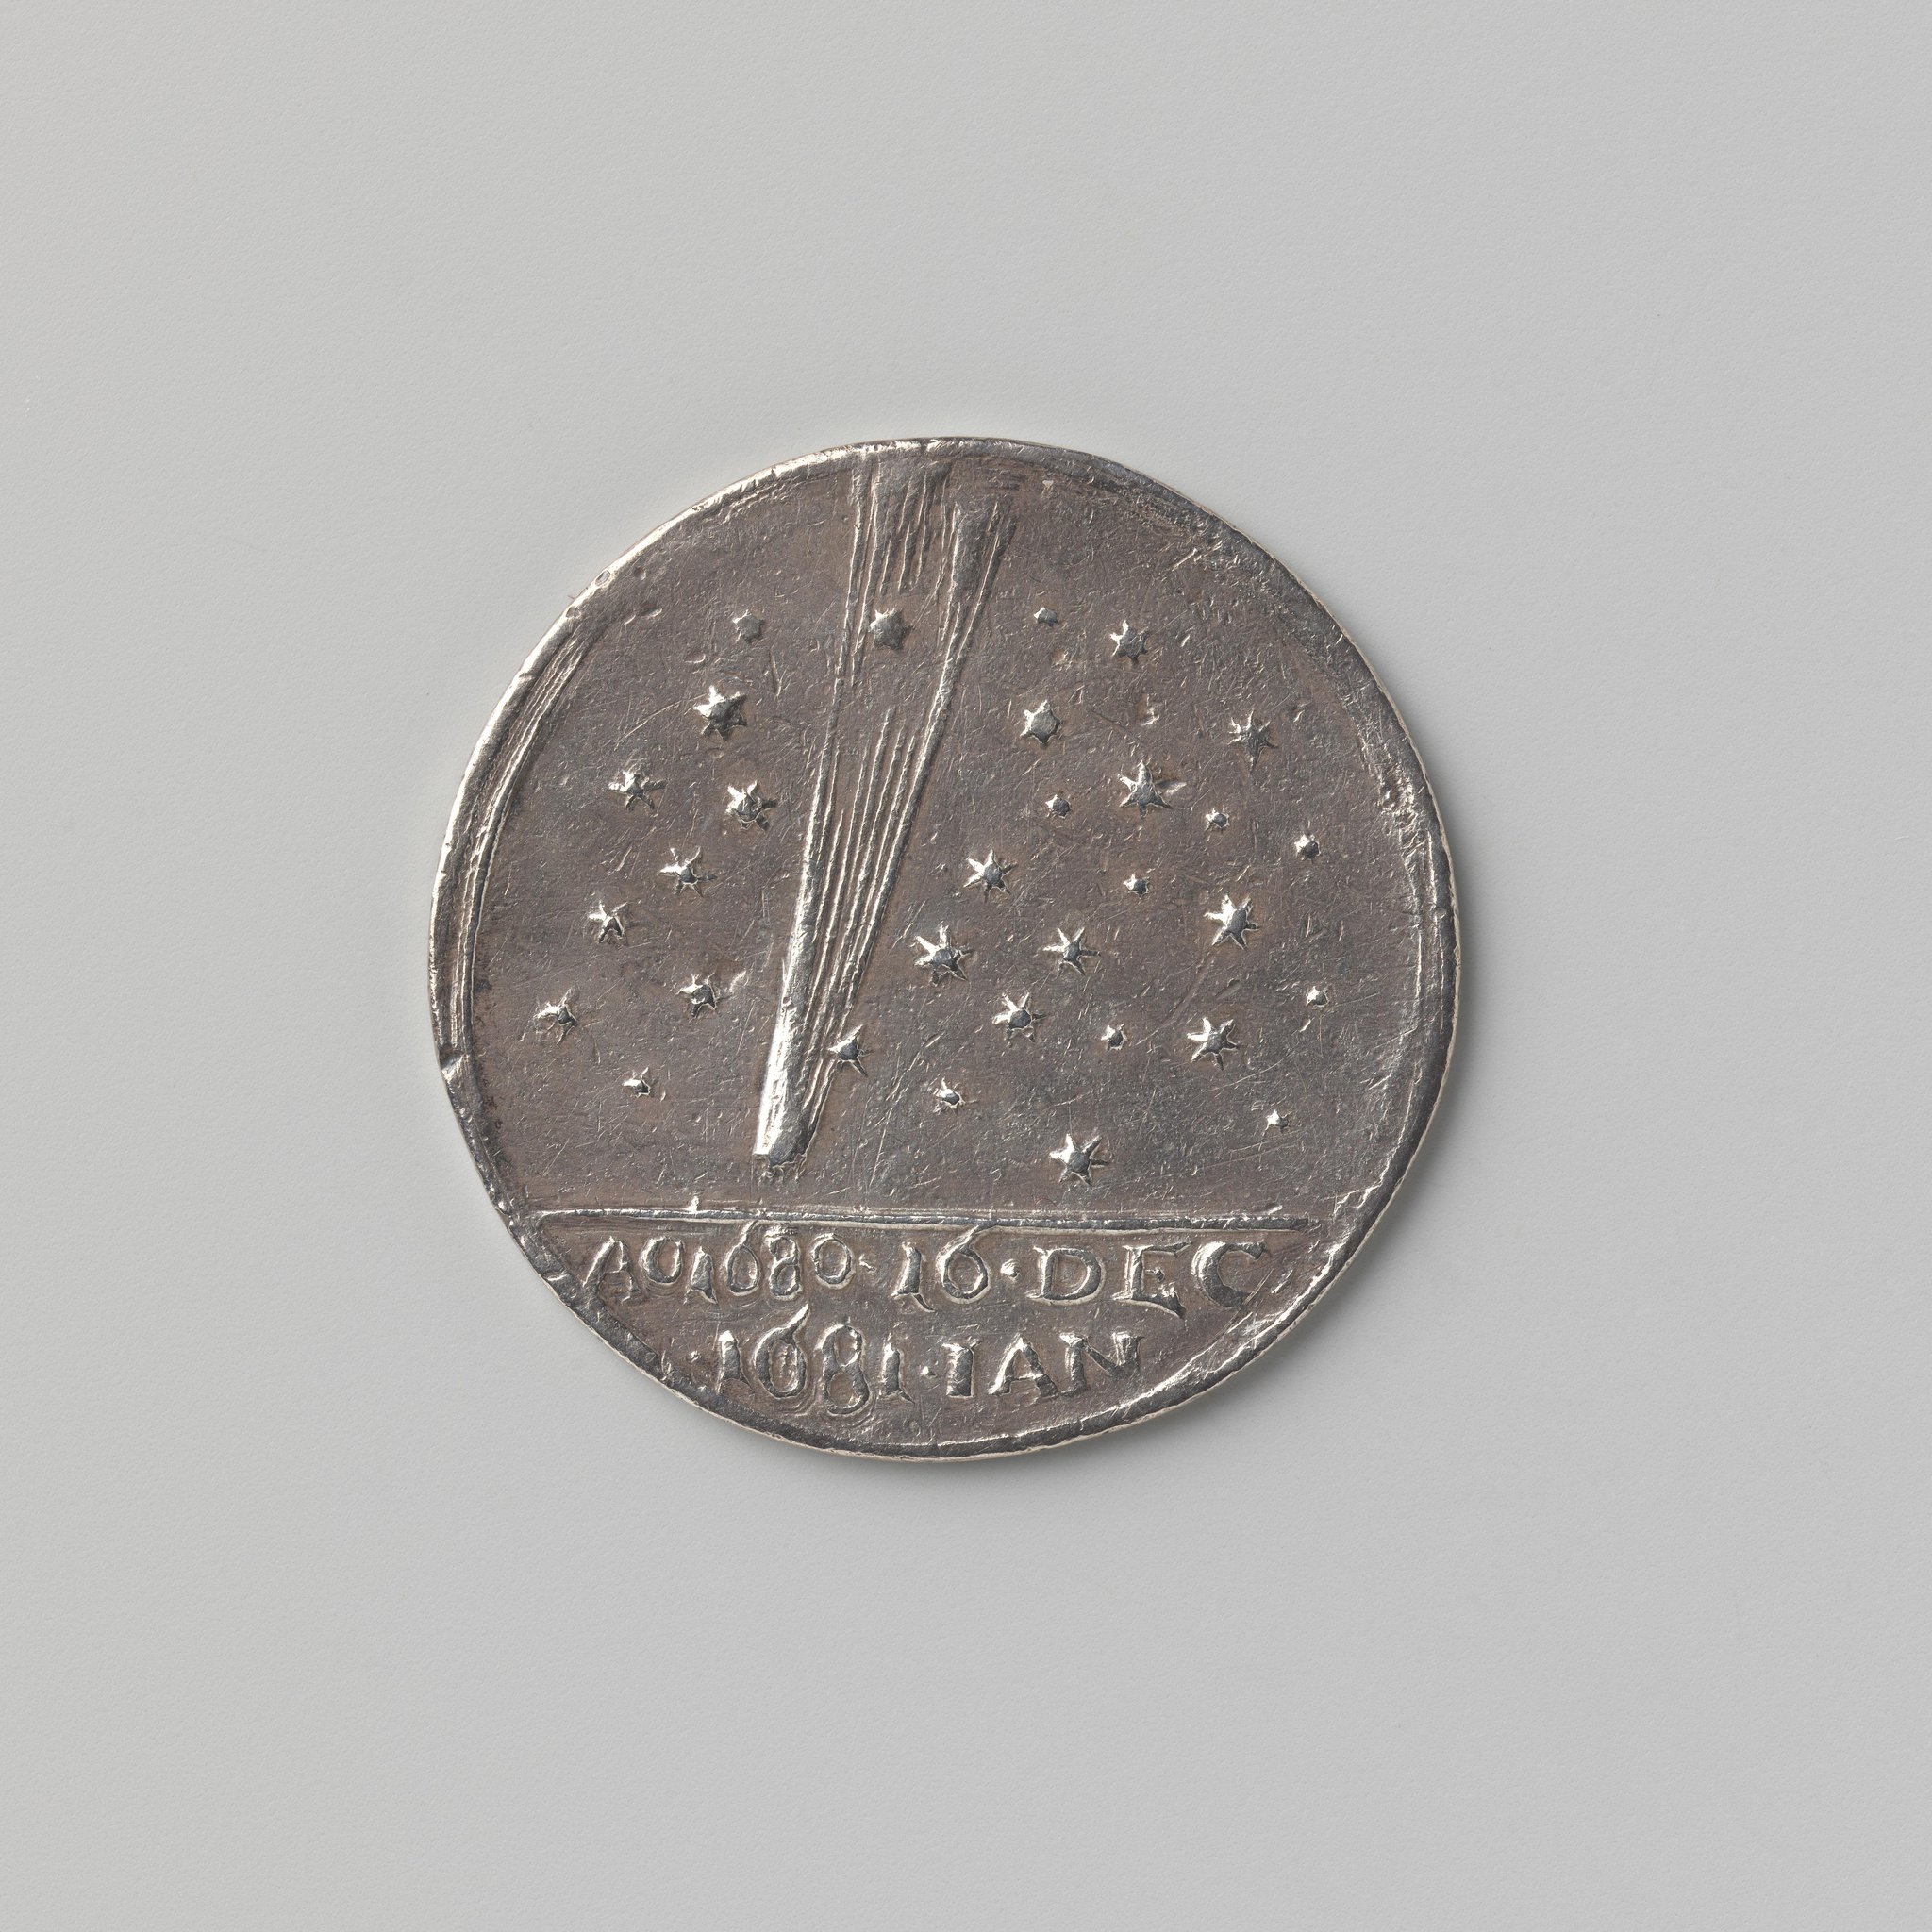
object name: history medal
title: Verschijning van een komeet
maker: Anonymous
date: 1681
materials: silver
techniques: striking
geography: germany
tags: netherlands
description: Zilveren penning. Voorzijde: de komeet temidden van een aantal sterren boven opschrift. Keerzijde: opschrift